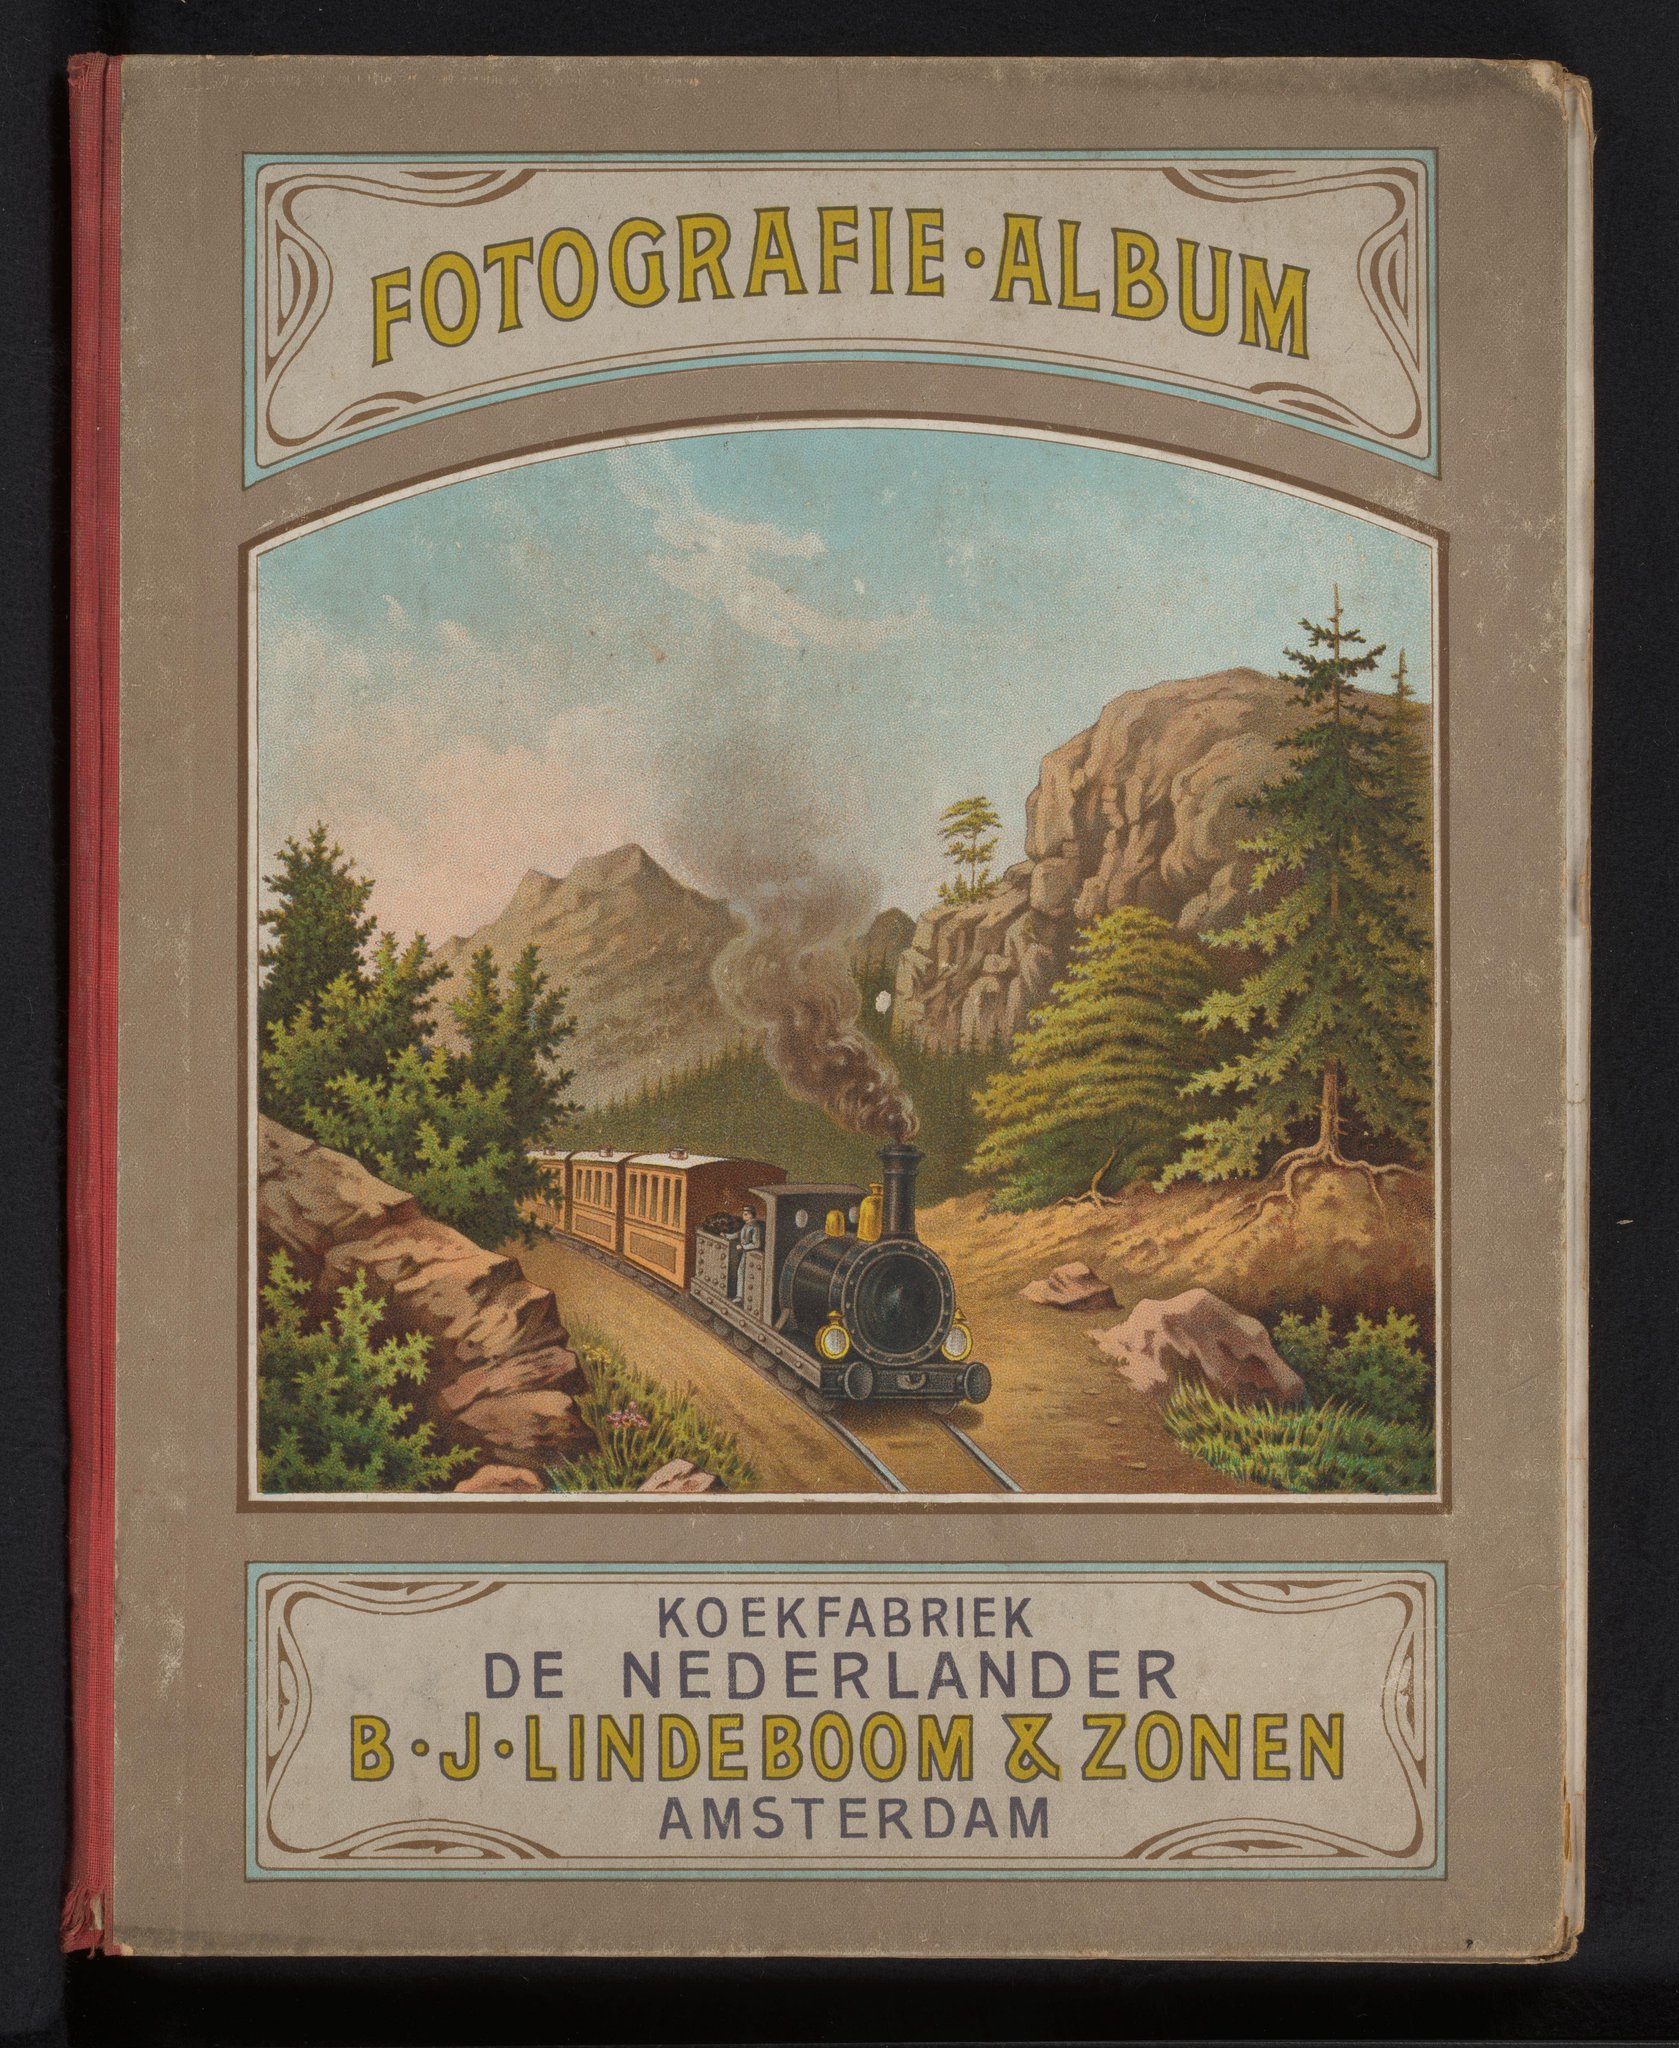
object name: slip in album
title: Verzamelalbum van koekfabriek De Nederlander met 131 foto's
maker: Anonymous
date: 1906-1907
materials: cardboard, paper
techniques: photograph, printing, printing block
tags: amsterdam, flushing, michiel adriaenszoon de ruyter, children's games and plays, city-view in general; 'veduta', river, historical persons - bb - woman, boy (child between toddler and youth), (story of) androclus, historical persons, girl (child between toddler and youth), tales and fairy tales (with title), tales and fairy tales, germany, pompeii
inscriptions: name: ‘E.B. Kastein’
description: Fotoalbum met betrekking tot de koekfabriek De Nederlander van B.J. Lindeboom & Zonen in Amsterdam. Het album bevat 24 pagina's met ieder 6 passe-partouts. Niet alle passe-partouts zijn gevuld. In totaal bevat het album 131 prenten. De prenten zaten als verzamelpaatjes bij producten van de koekfabriek voor de jaargang 1906 - 1907. Verzamelaars konden een jaar lang prenten sparen voor elk album. De prenten zijn ingedeeld in thema's, die ieder 1 of 2 pagina's beslaan. Een aantal thema's in dit album zijn sprookjes en mythen, dorpsgezichten, ruïnes, spelende kinderen en het productieproces van rijst en koffie.